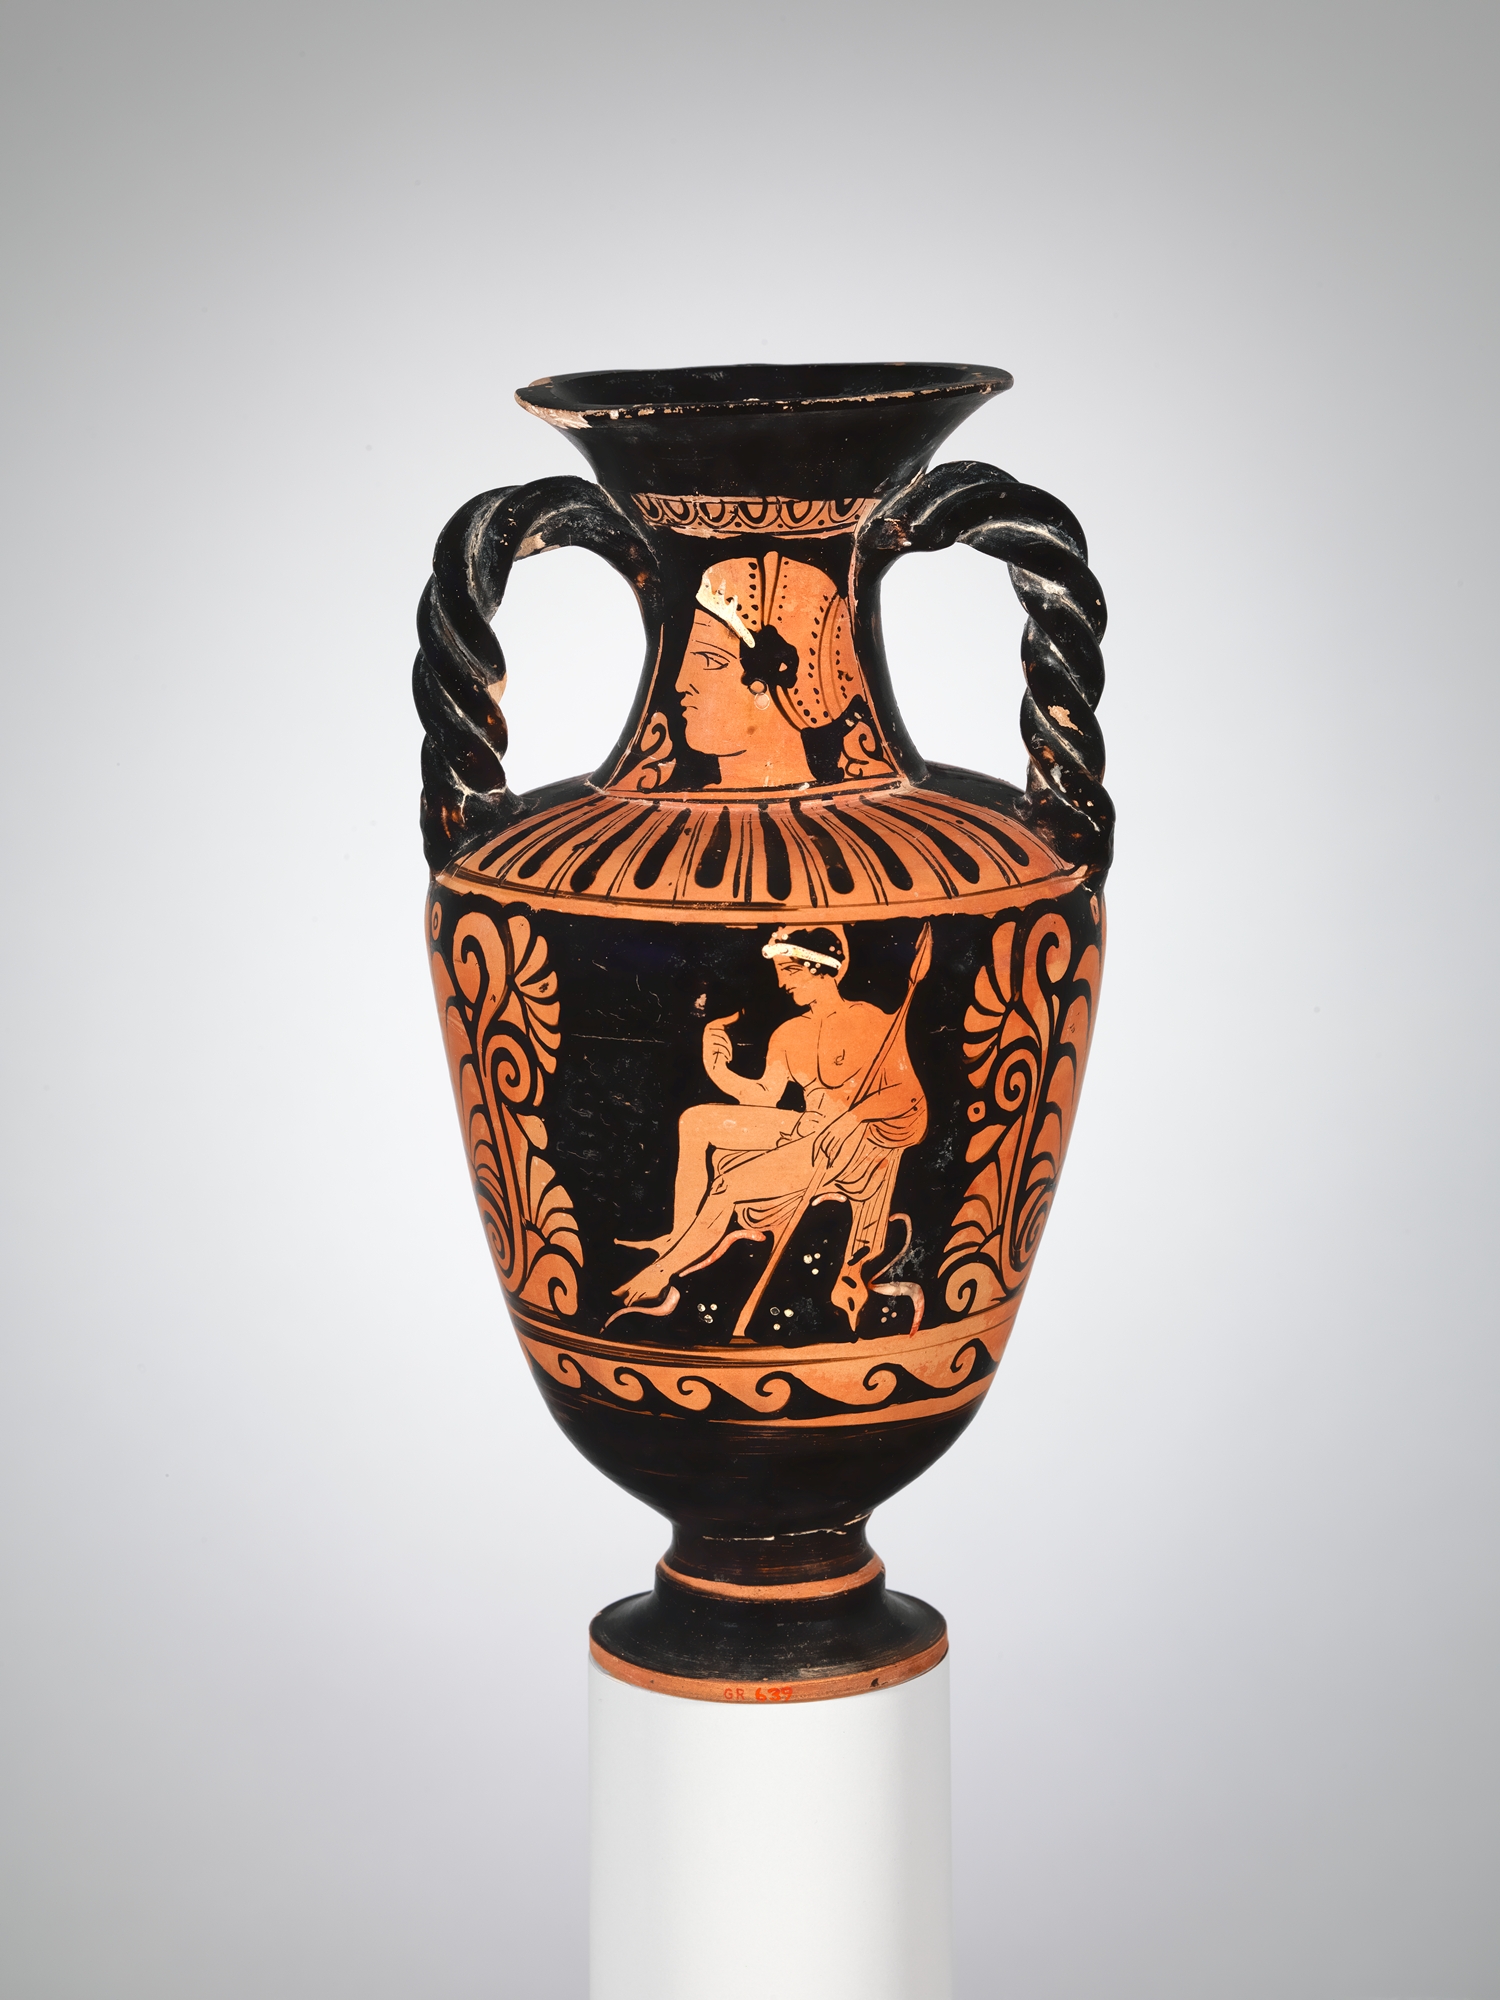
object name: neck amphora with twisted handle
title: Terracotta neck-amphora with twisted handles (jar)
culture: greek or south italian or campanian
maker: pilos head group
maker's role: artist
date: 350-325 BCE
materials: terracotta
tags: male nudes,warriors